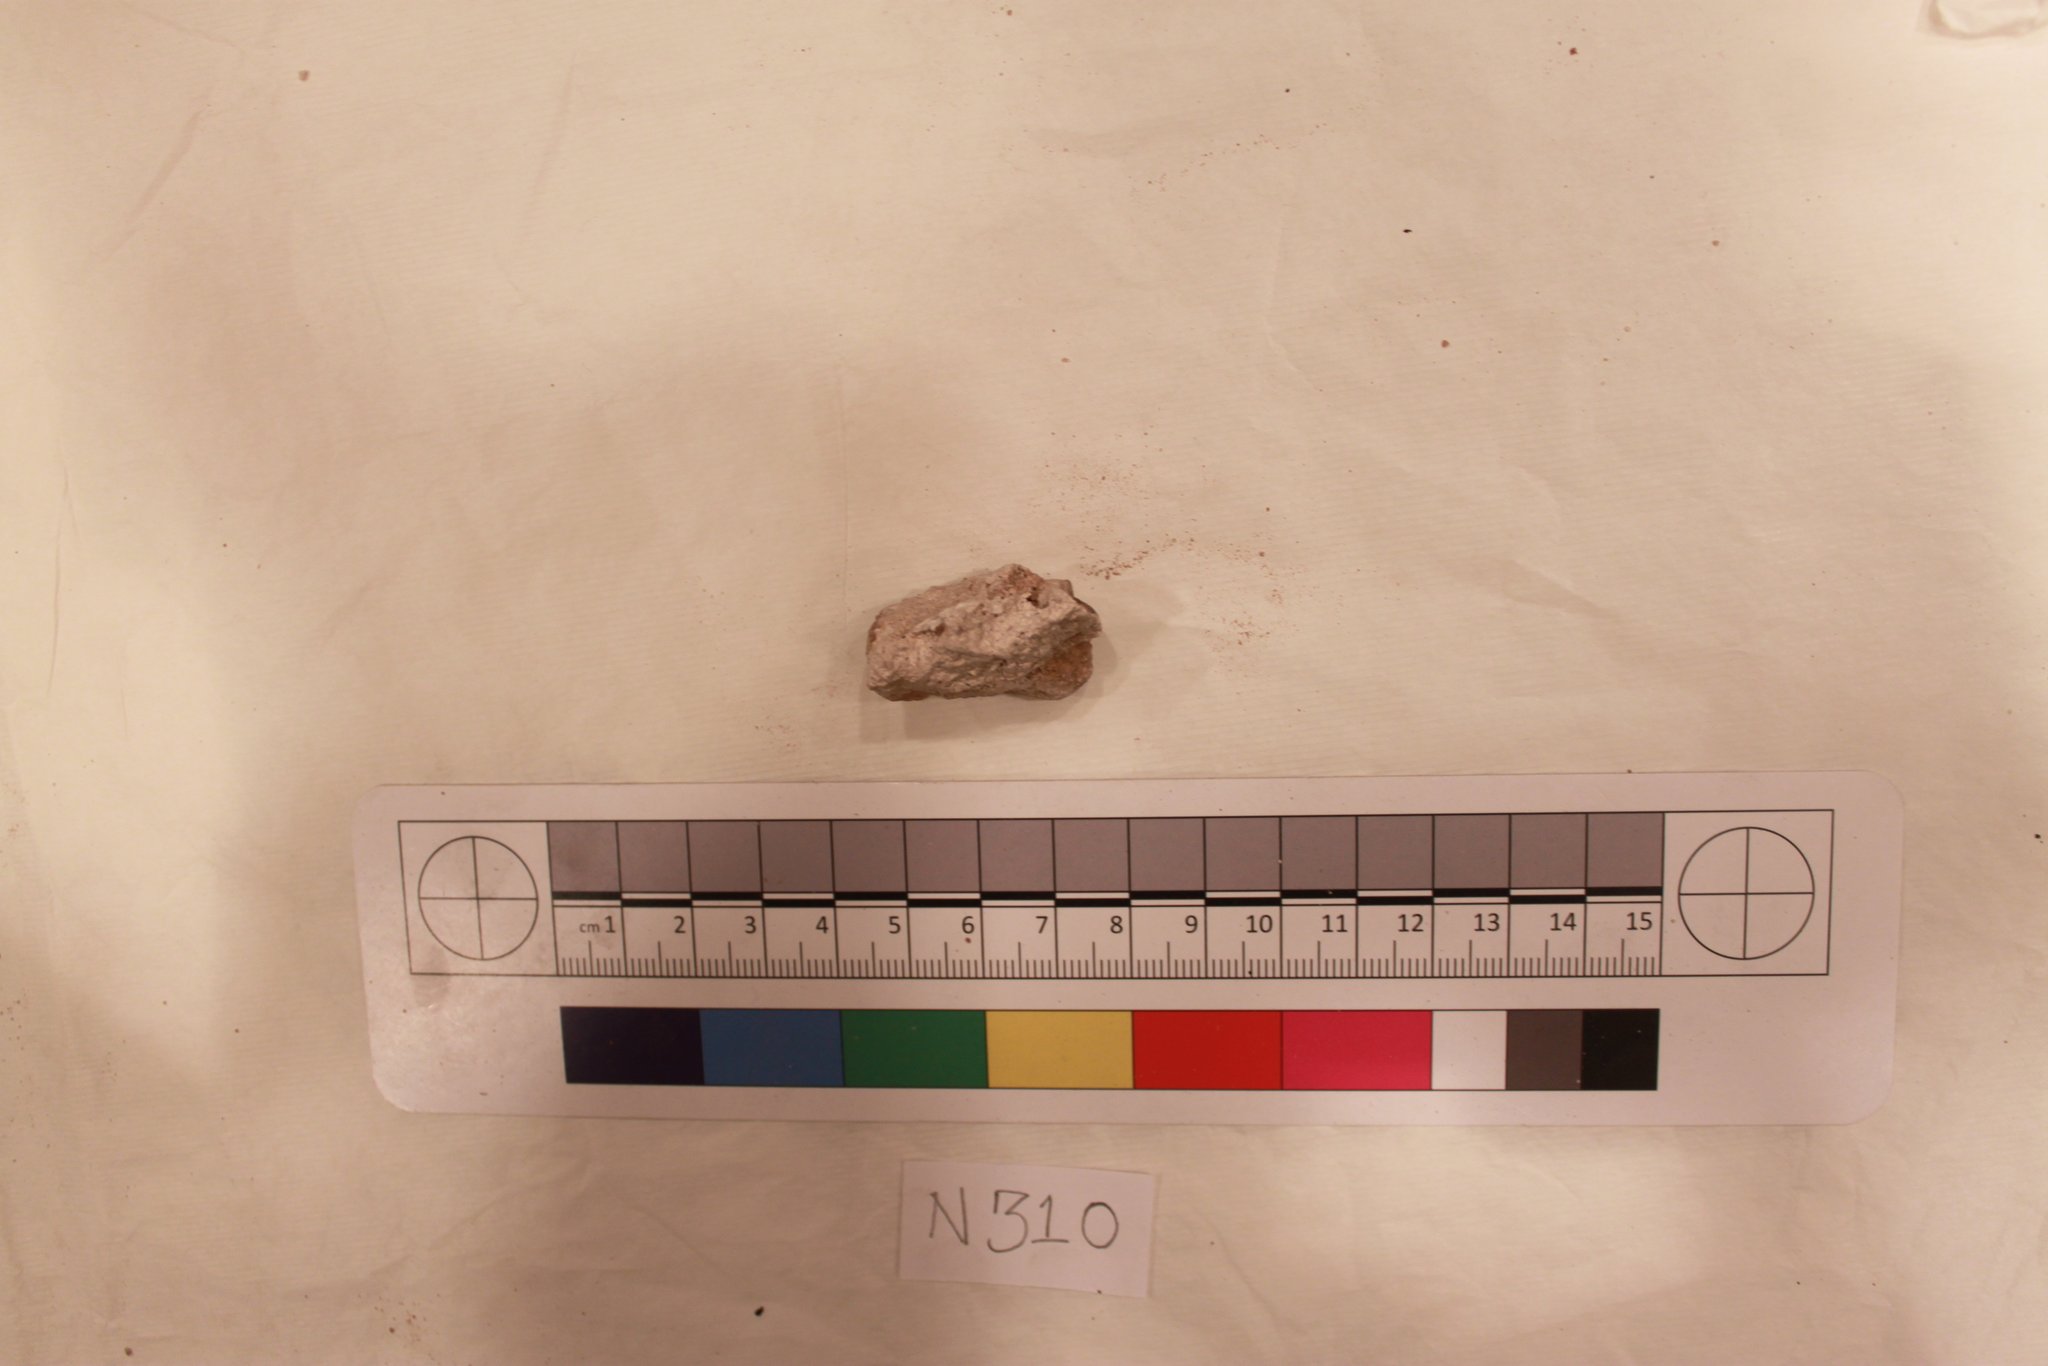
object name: fragment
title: Stucco Fragment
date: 701-1200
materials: plaster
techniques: carving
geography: iran